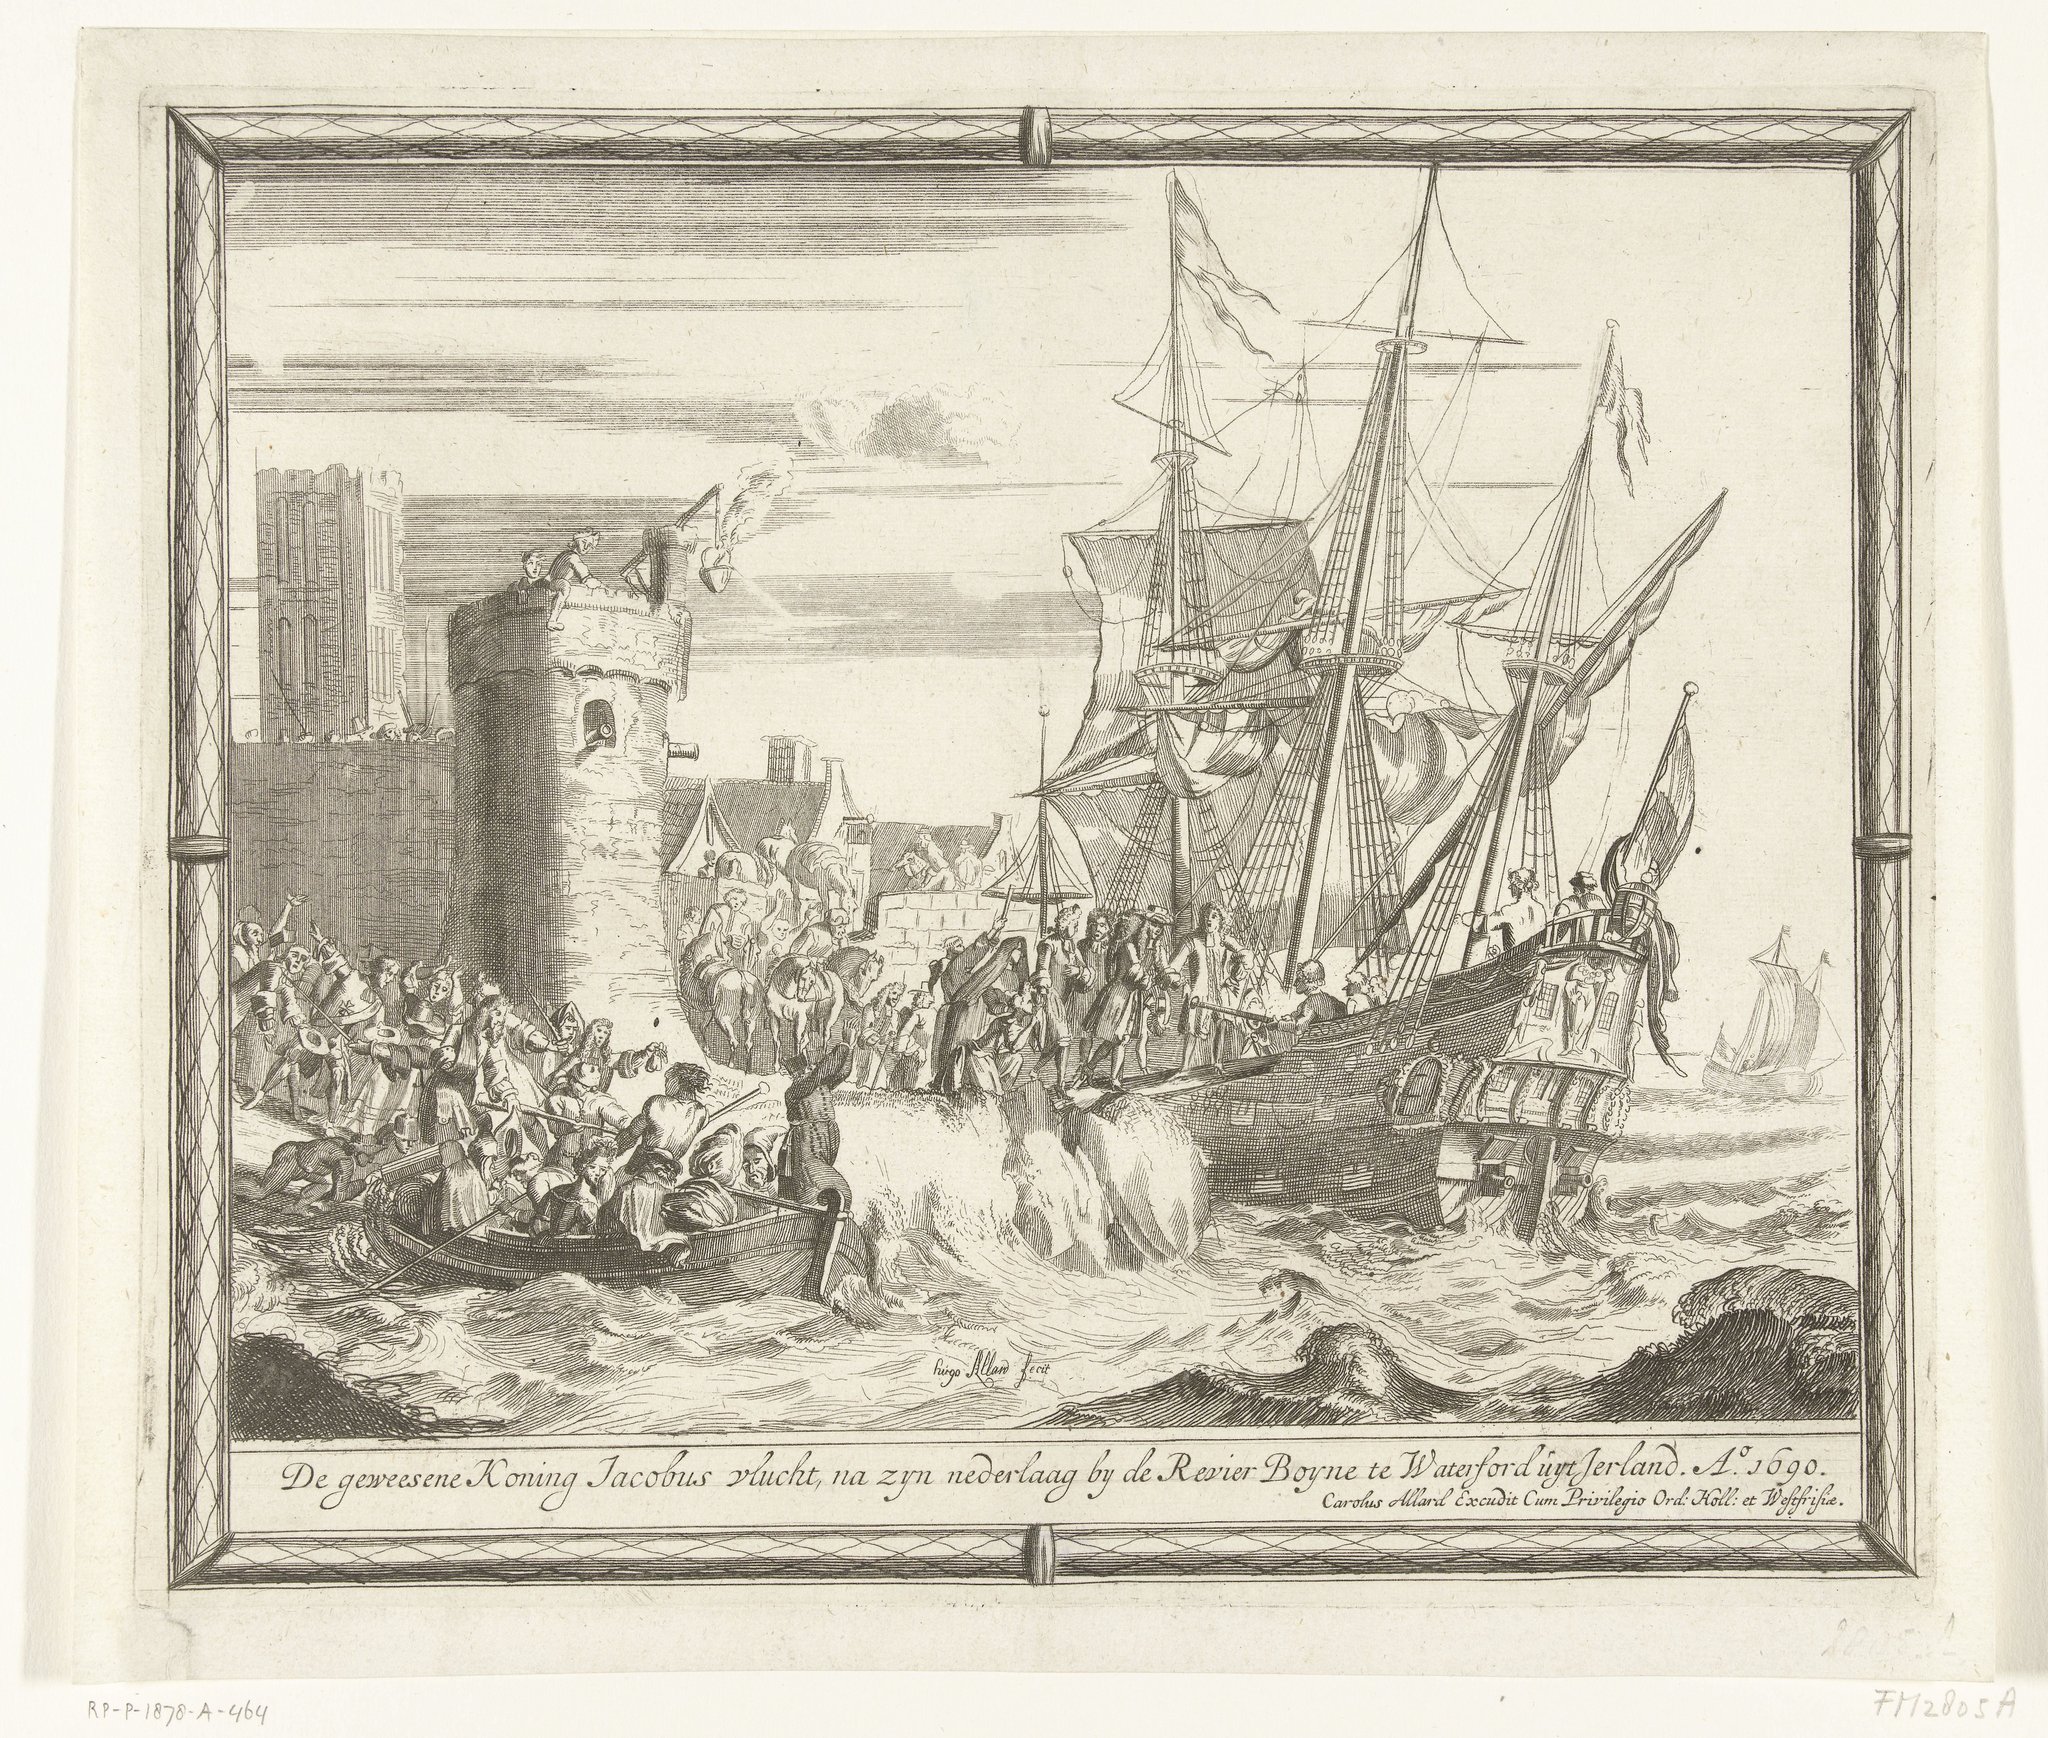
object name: print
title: Vlucht van Jacobus na zijn nederlaag bij de Boyne, 1690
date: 1691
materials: paper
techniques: etching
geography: northern netherlands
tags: jacobus ii (koning van engeland en schotland)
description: Vlucht van koning Jacobus naar Frankrijk op 12 juli 1690 na zijn nederlaag tegen het leger van Willem III in de Slag aan de Boyne. De koning gaat in Waterford aan boord van een schip. Plaat 16 in een serie van 20 platen over de Glorious Revolution in Engeland in de jaren 1688-1691.